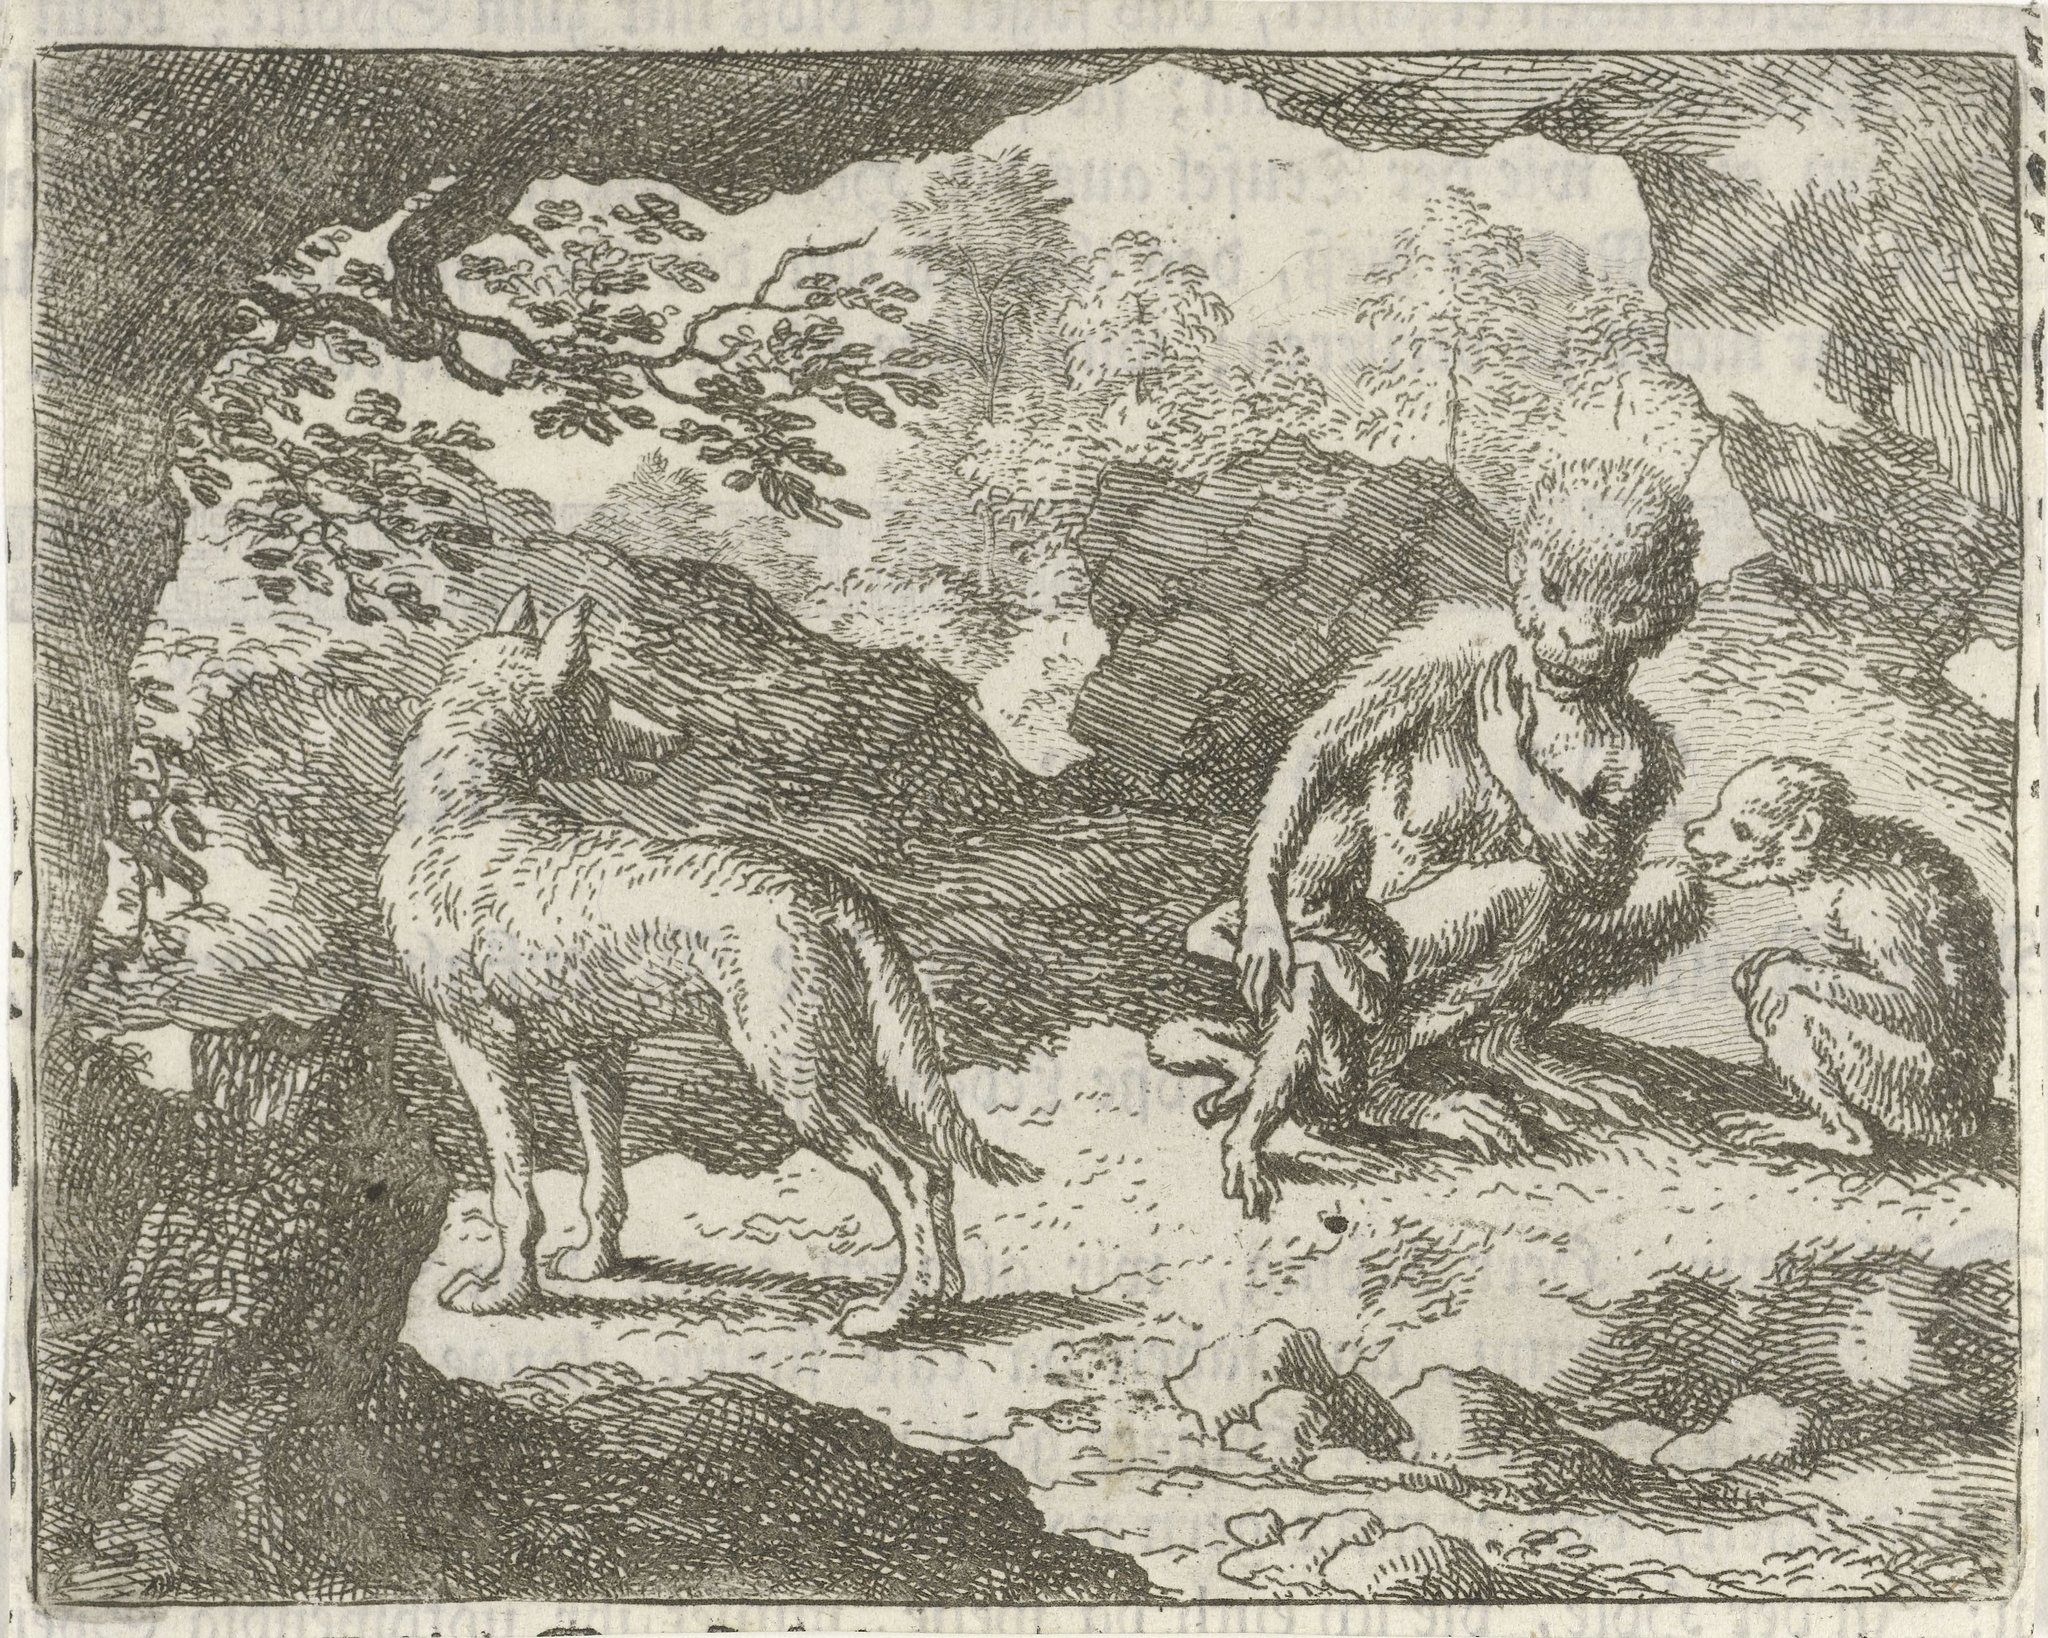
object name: print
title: Reinaert de vos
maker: allaert van everdingen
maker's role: draughtsman, painter, print maker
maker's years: 1621-1675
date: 1665-1675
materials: paper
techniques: etching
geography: netherlands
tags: fable of reynard the fox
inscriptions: collector's mark: Lugt 2228